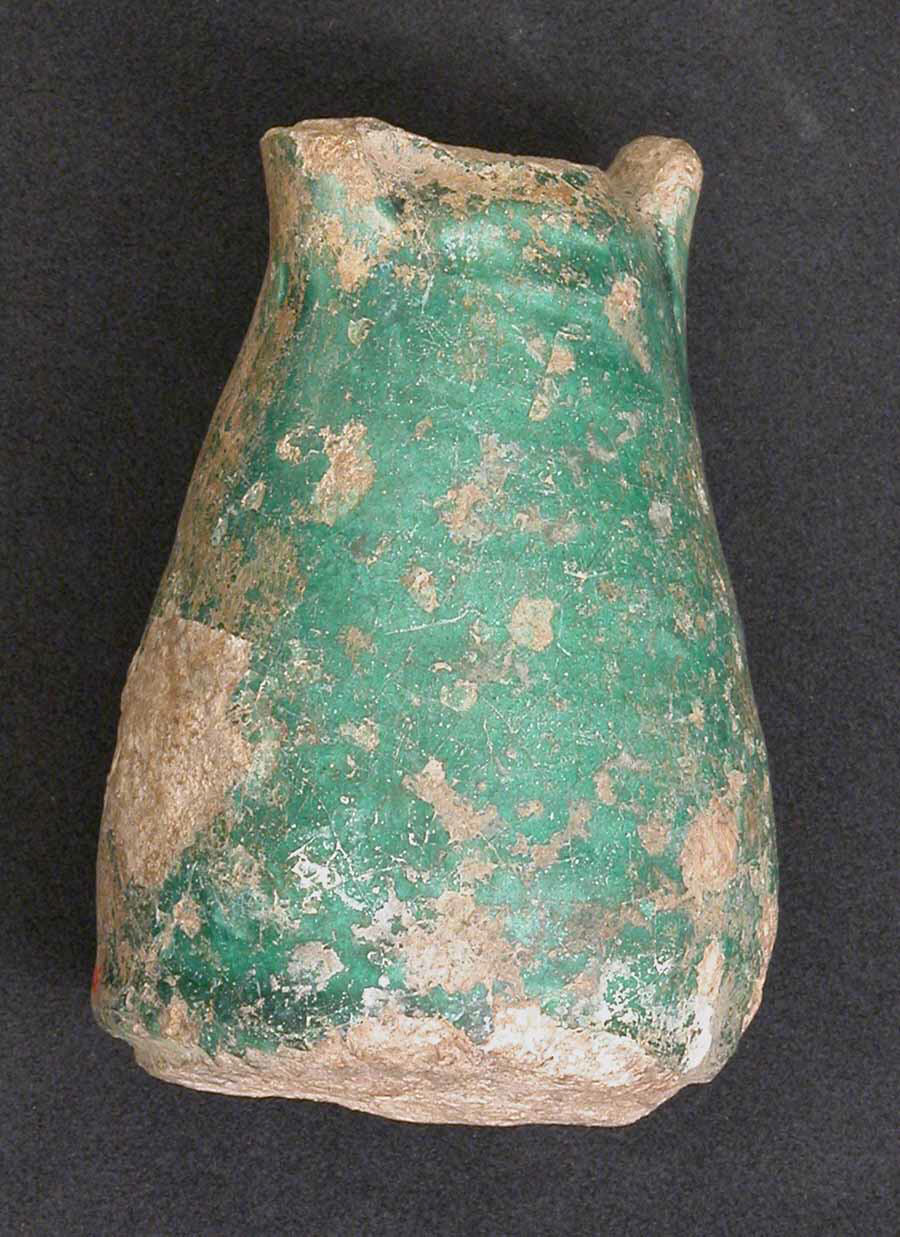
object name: jar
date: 501-600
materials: earthenware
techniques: glazing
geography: iran